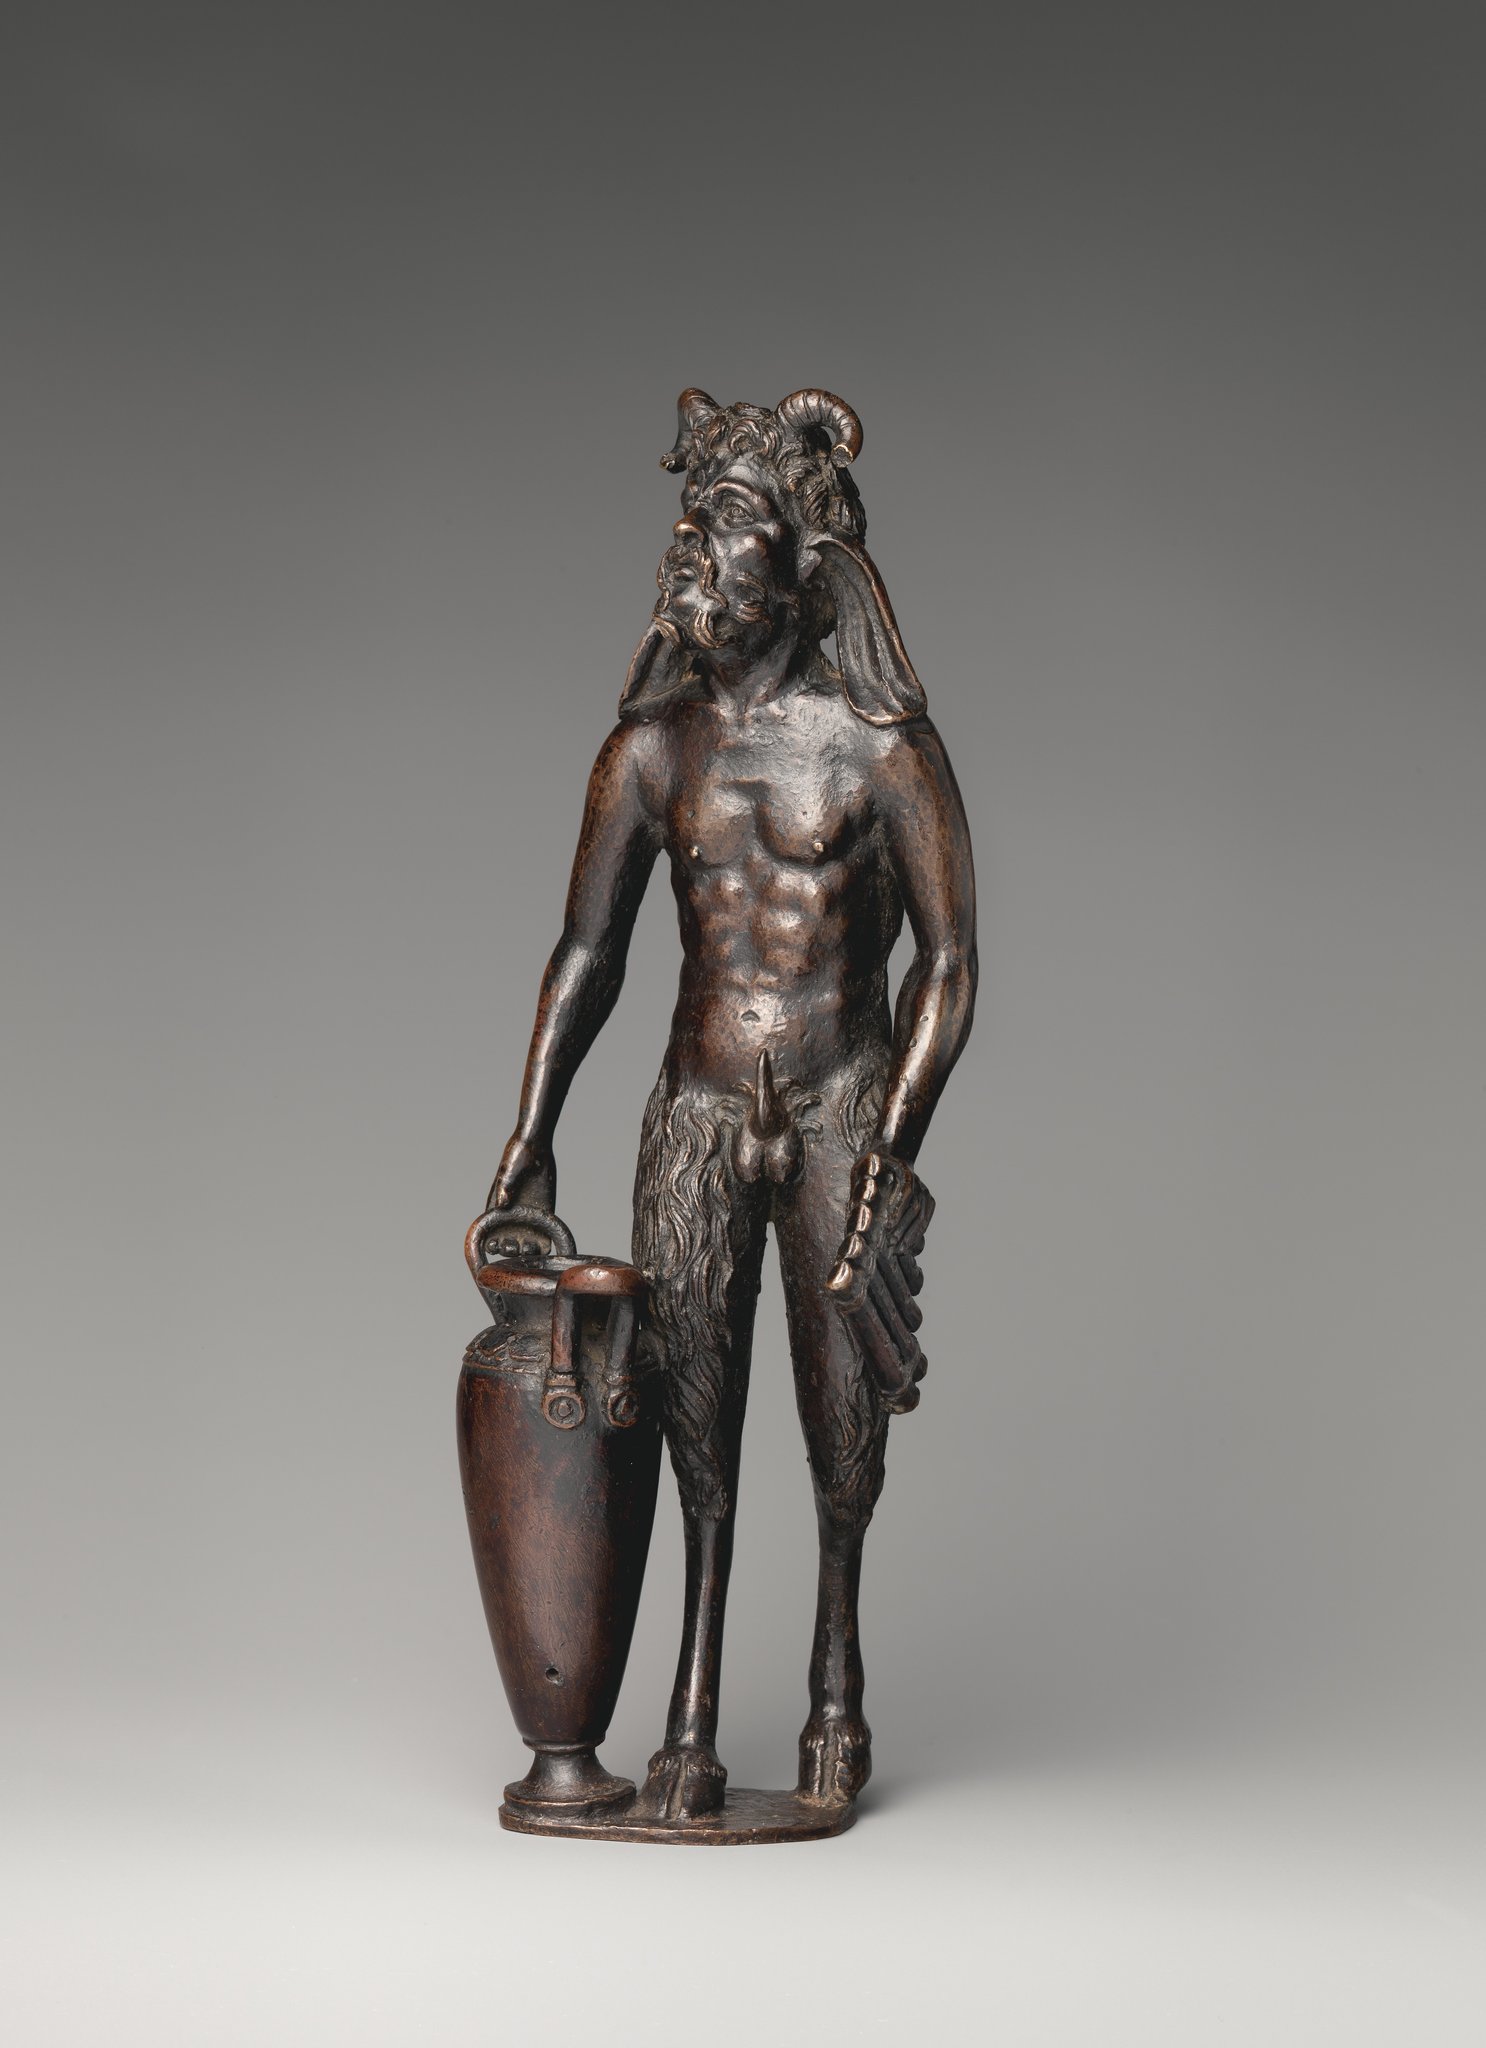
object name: statuette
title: Satyr with vase (one of a pair)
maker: andrea briosco, called riccio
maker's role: artist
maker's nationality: italian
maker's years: 1470-1532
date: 1540-1550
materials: bronze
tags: satyrs,urns